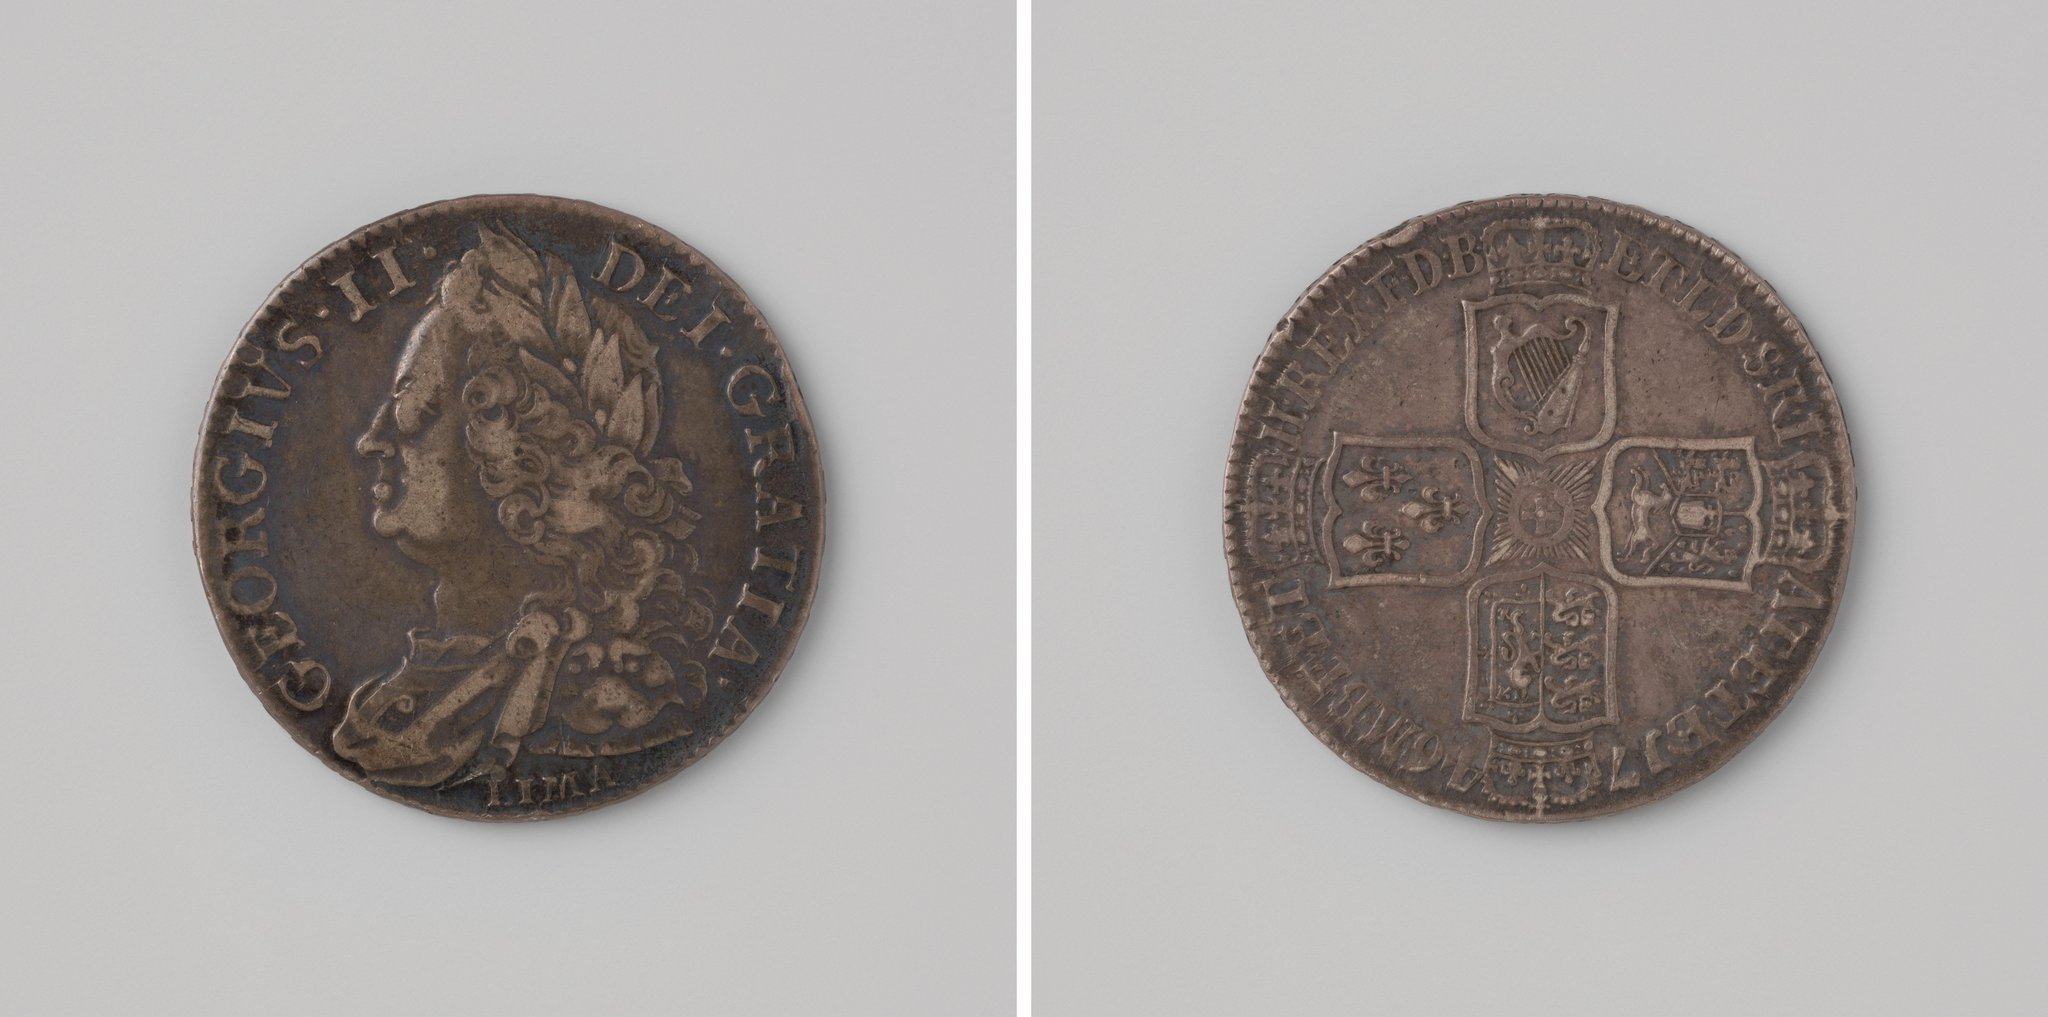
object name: coin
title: Munt van een halve crown van George II, koning van Engeland, munt geslagen van het te Lima buitgemaakte zilver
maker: Anonymous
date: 1746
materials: silver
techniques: striking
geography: england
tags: london, george ii augustus (koning van groot-brittannië)